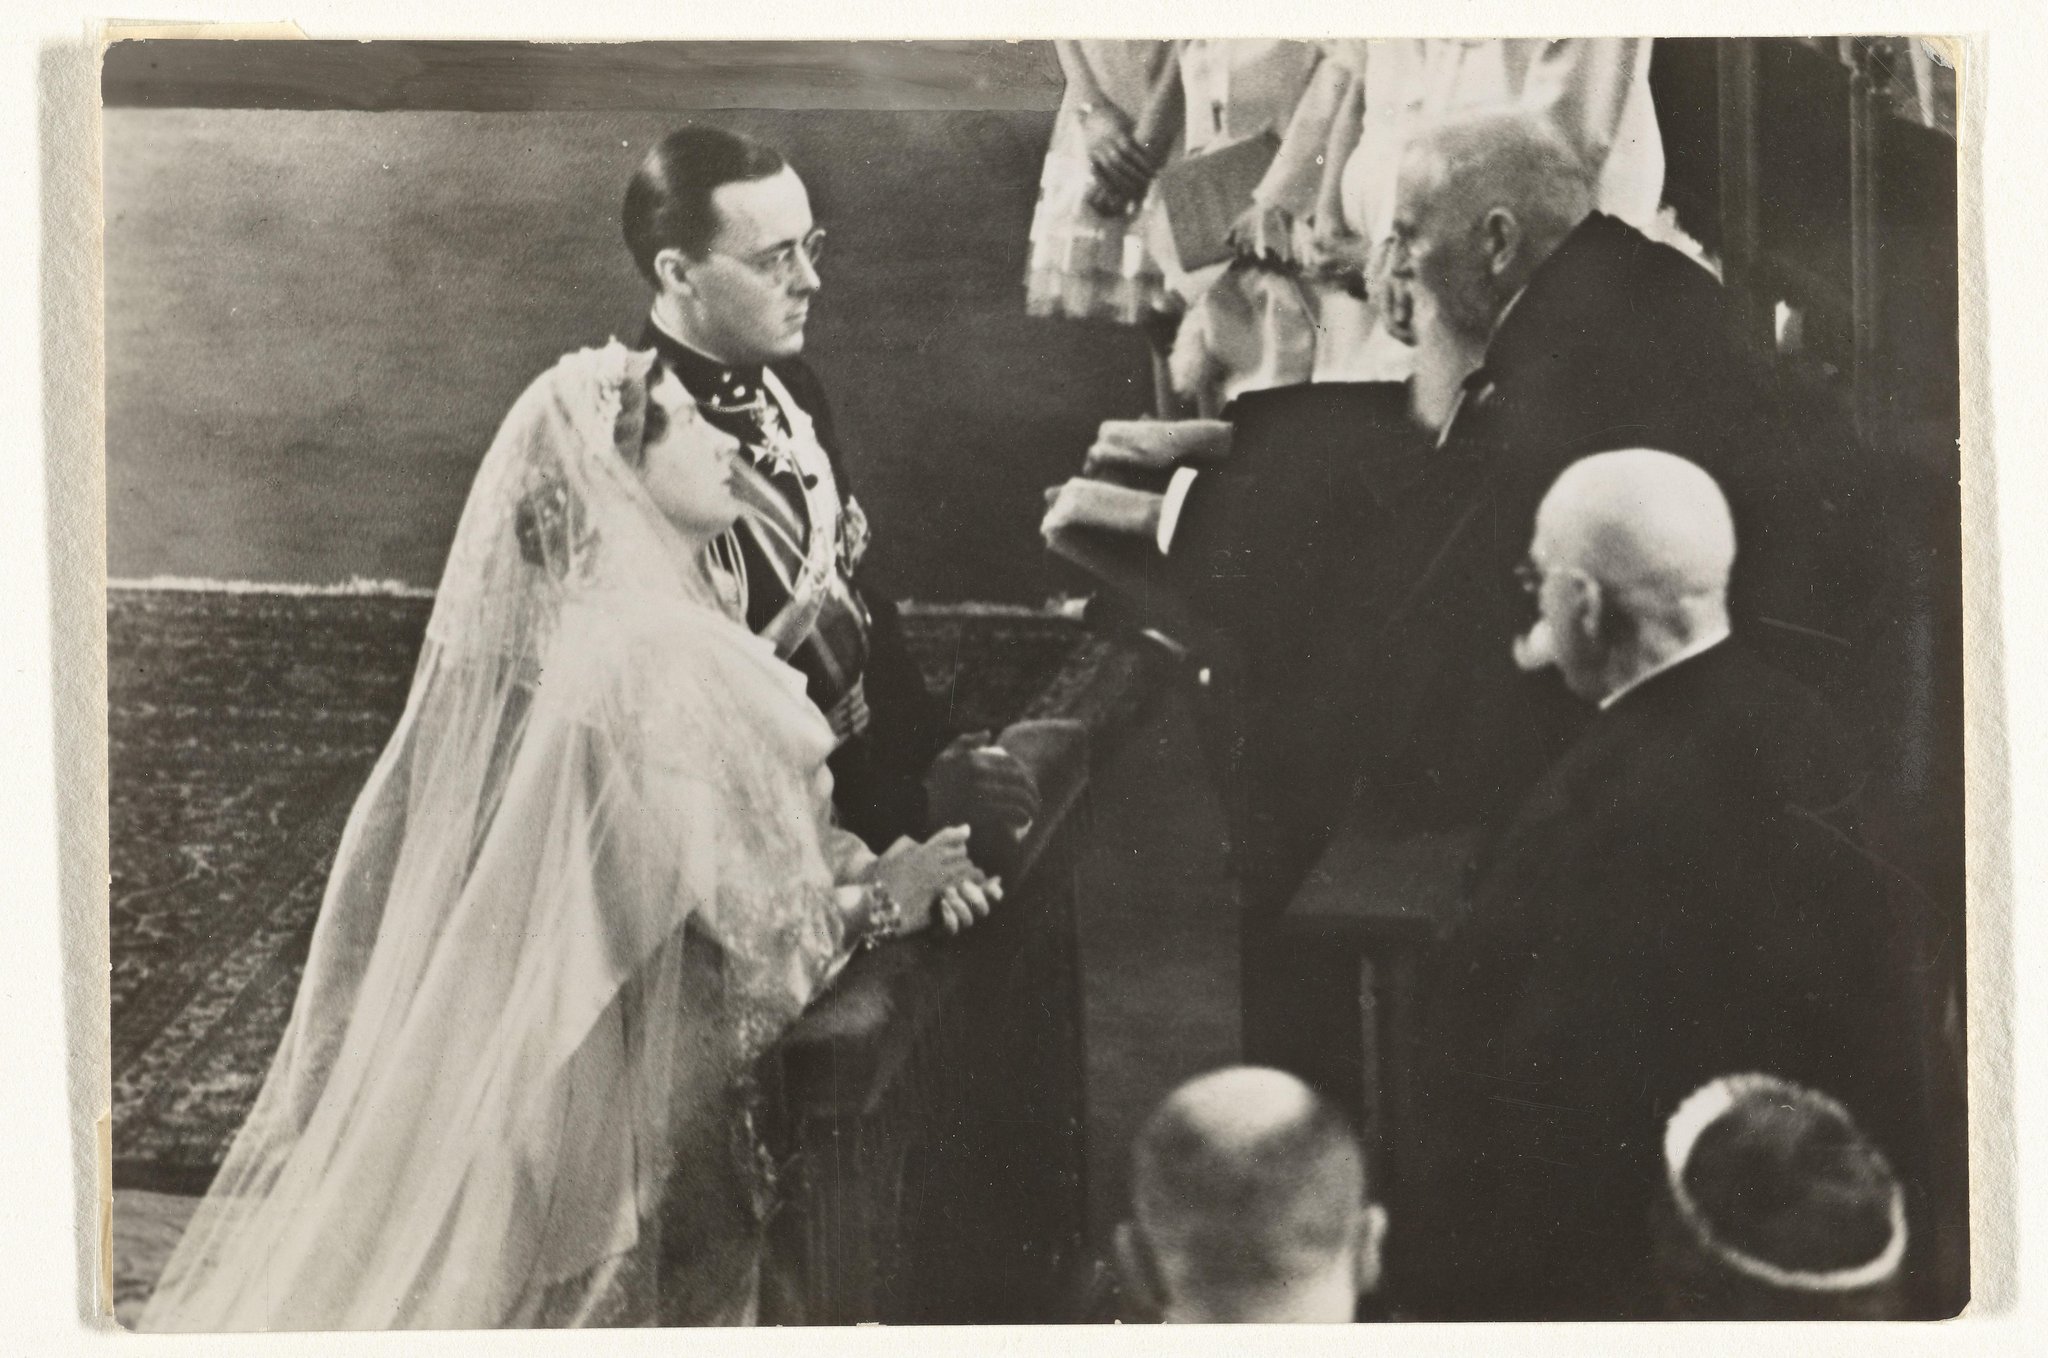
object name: ansichtkaart, prentbriefkaart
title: Huwelijk van prinses Juliana en prins Bernard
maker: erich salomon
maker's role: fotograaf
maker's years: 1886-1944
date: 1937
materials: paper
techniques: gelatin silver print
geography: the hague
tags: bernhard (prins der nederlanden), the hague, juliana of the netherlands, civil marriage ceremony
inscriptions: inscription: ‘De inzegening/ van/ het huwelijk/ van hunne Koninklijke Hoogheden/ Prinses Juliana en Prins Bernhard/ in de St. Jacobskerk te 's Gravenhage/ 7 januari 1937/ Uitgave van weekblad "Het Leven"/ Copyright Dr. Erich Salamon’